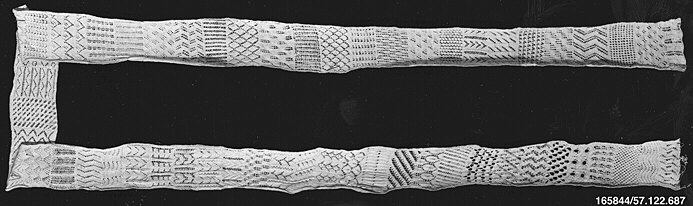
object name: sampler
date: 1801-1900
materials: lace, wool